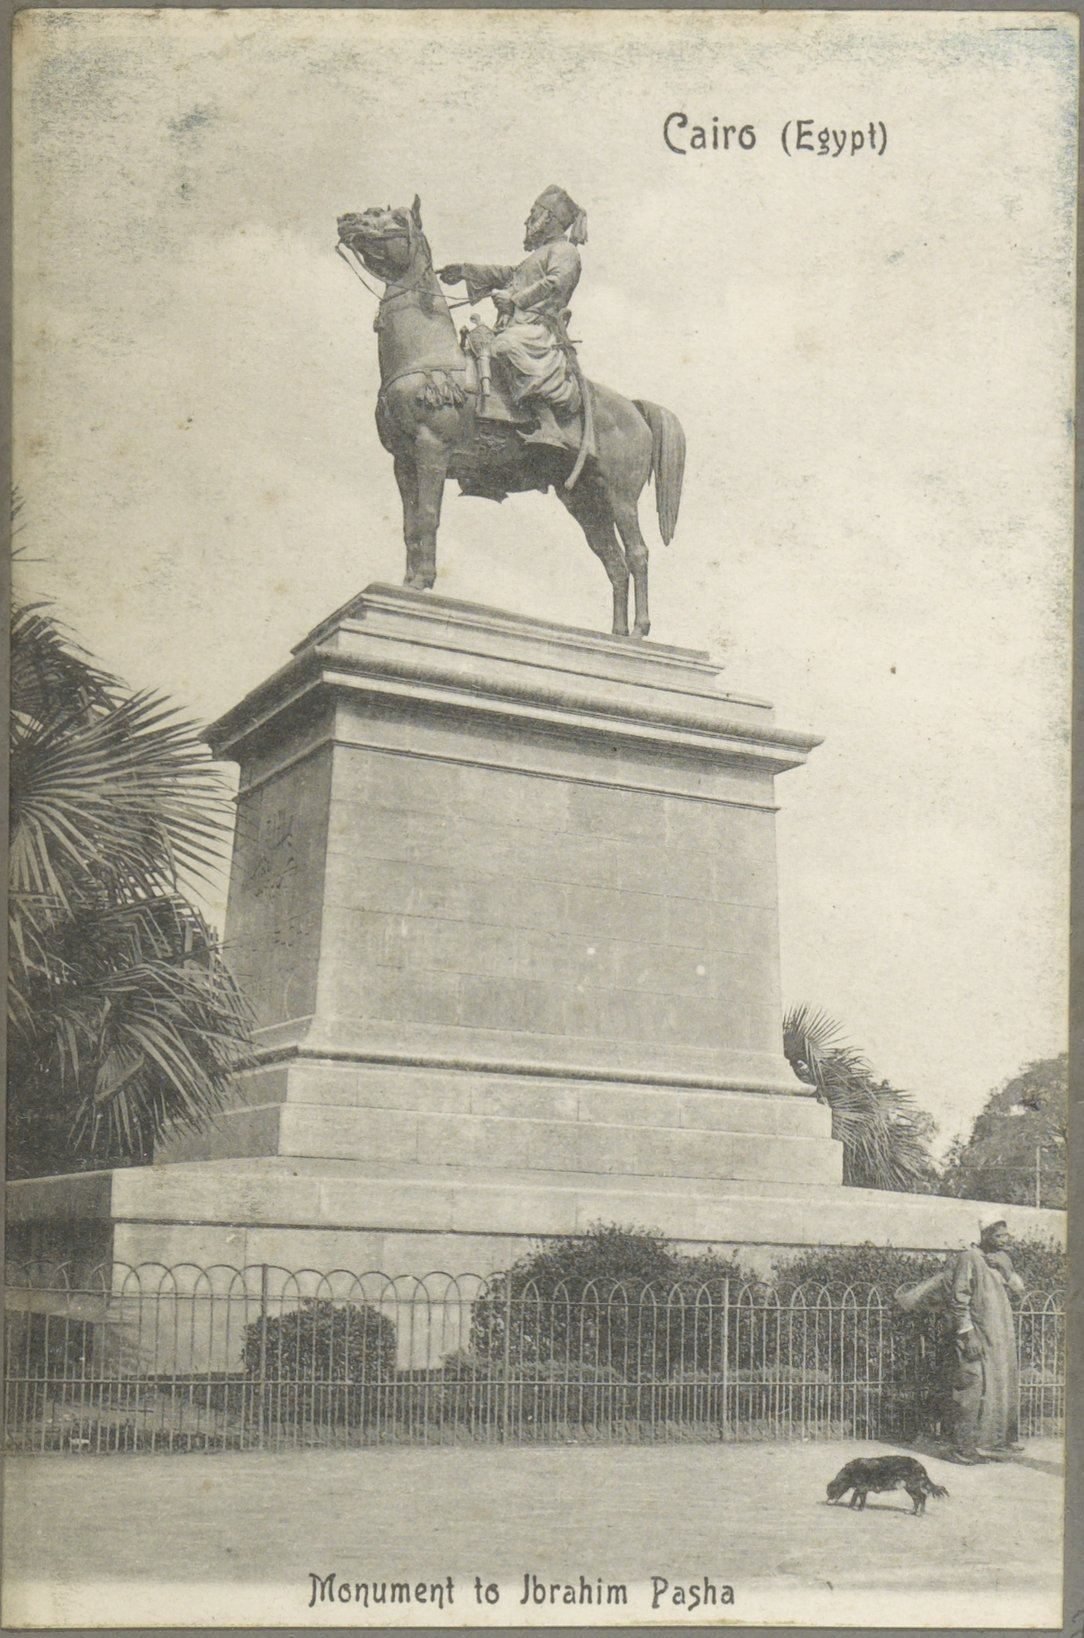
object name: ansichtkaart, prentbriefkaart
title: Plein in Caïro met het ruiterstandbeeld van Ibrahim Pasja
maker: Anonymous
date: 1895-1905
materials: paper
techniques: photograph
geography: cairo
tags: equestrian statue, square, place, circus, etc. (+ city(-scape) with figures, staffage)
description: Onderdeel van Reisalbum met foto's van bezienswaardigheden in Griekenland en Egypte.